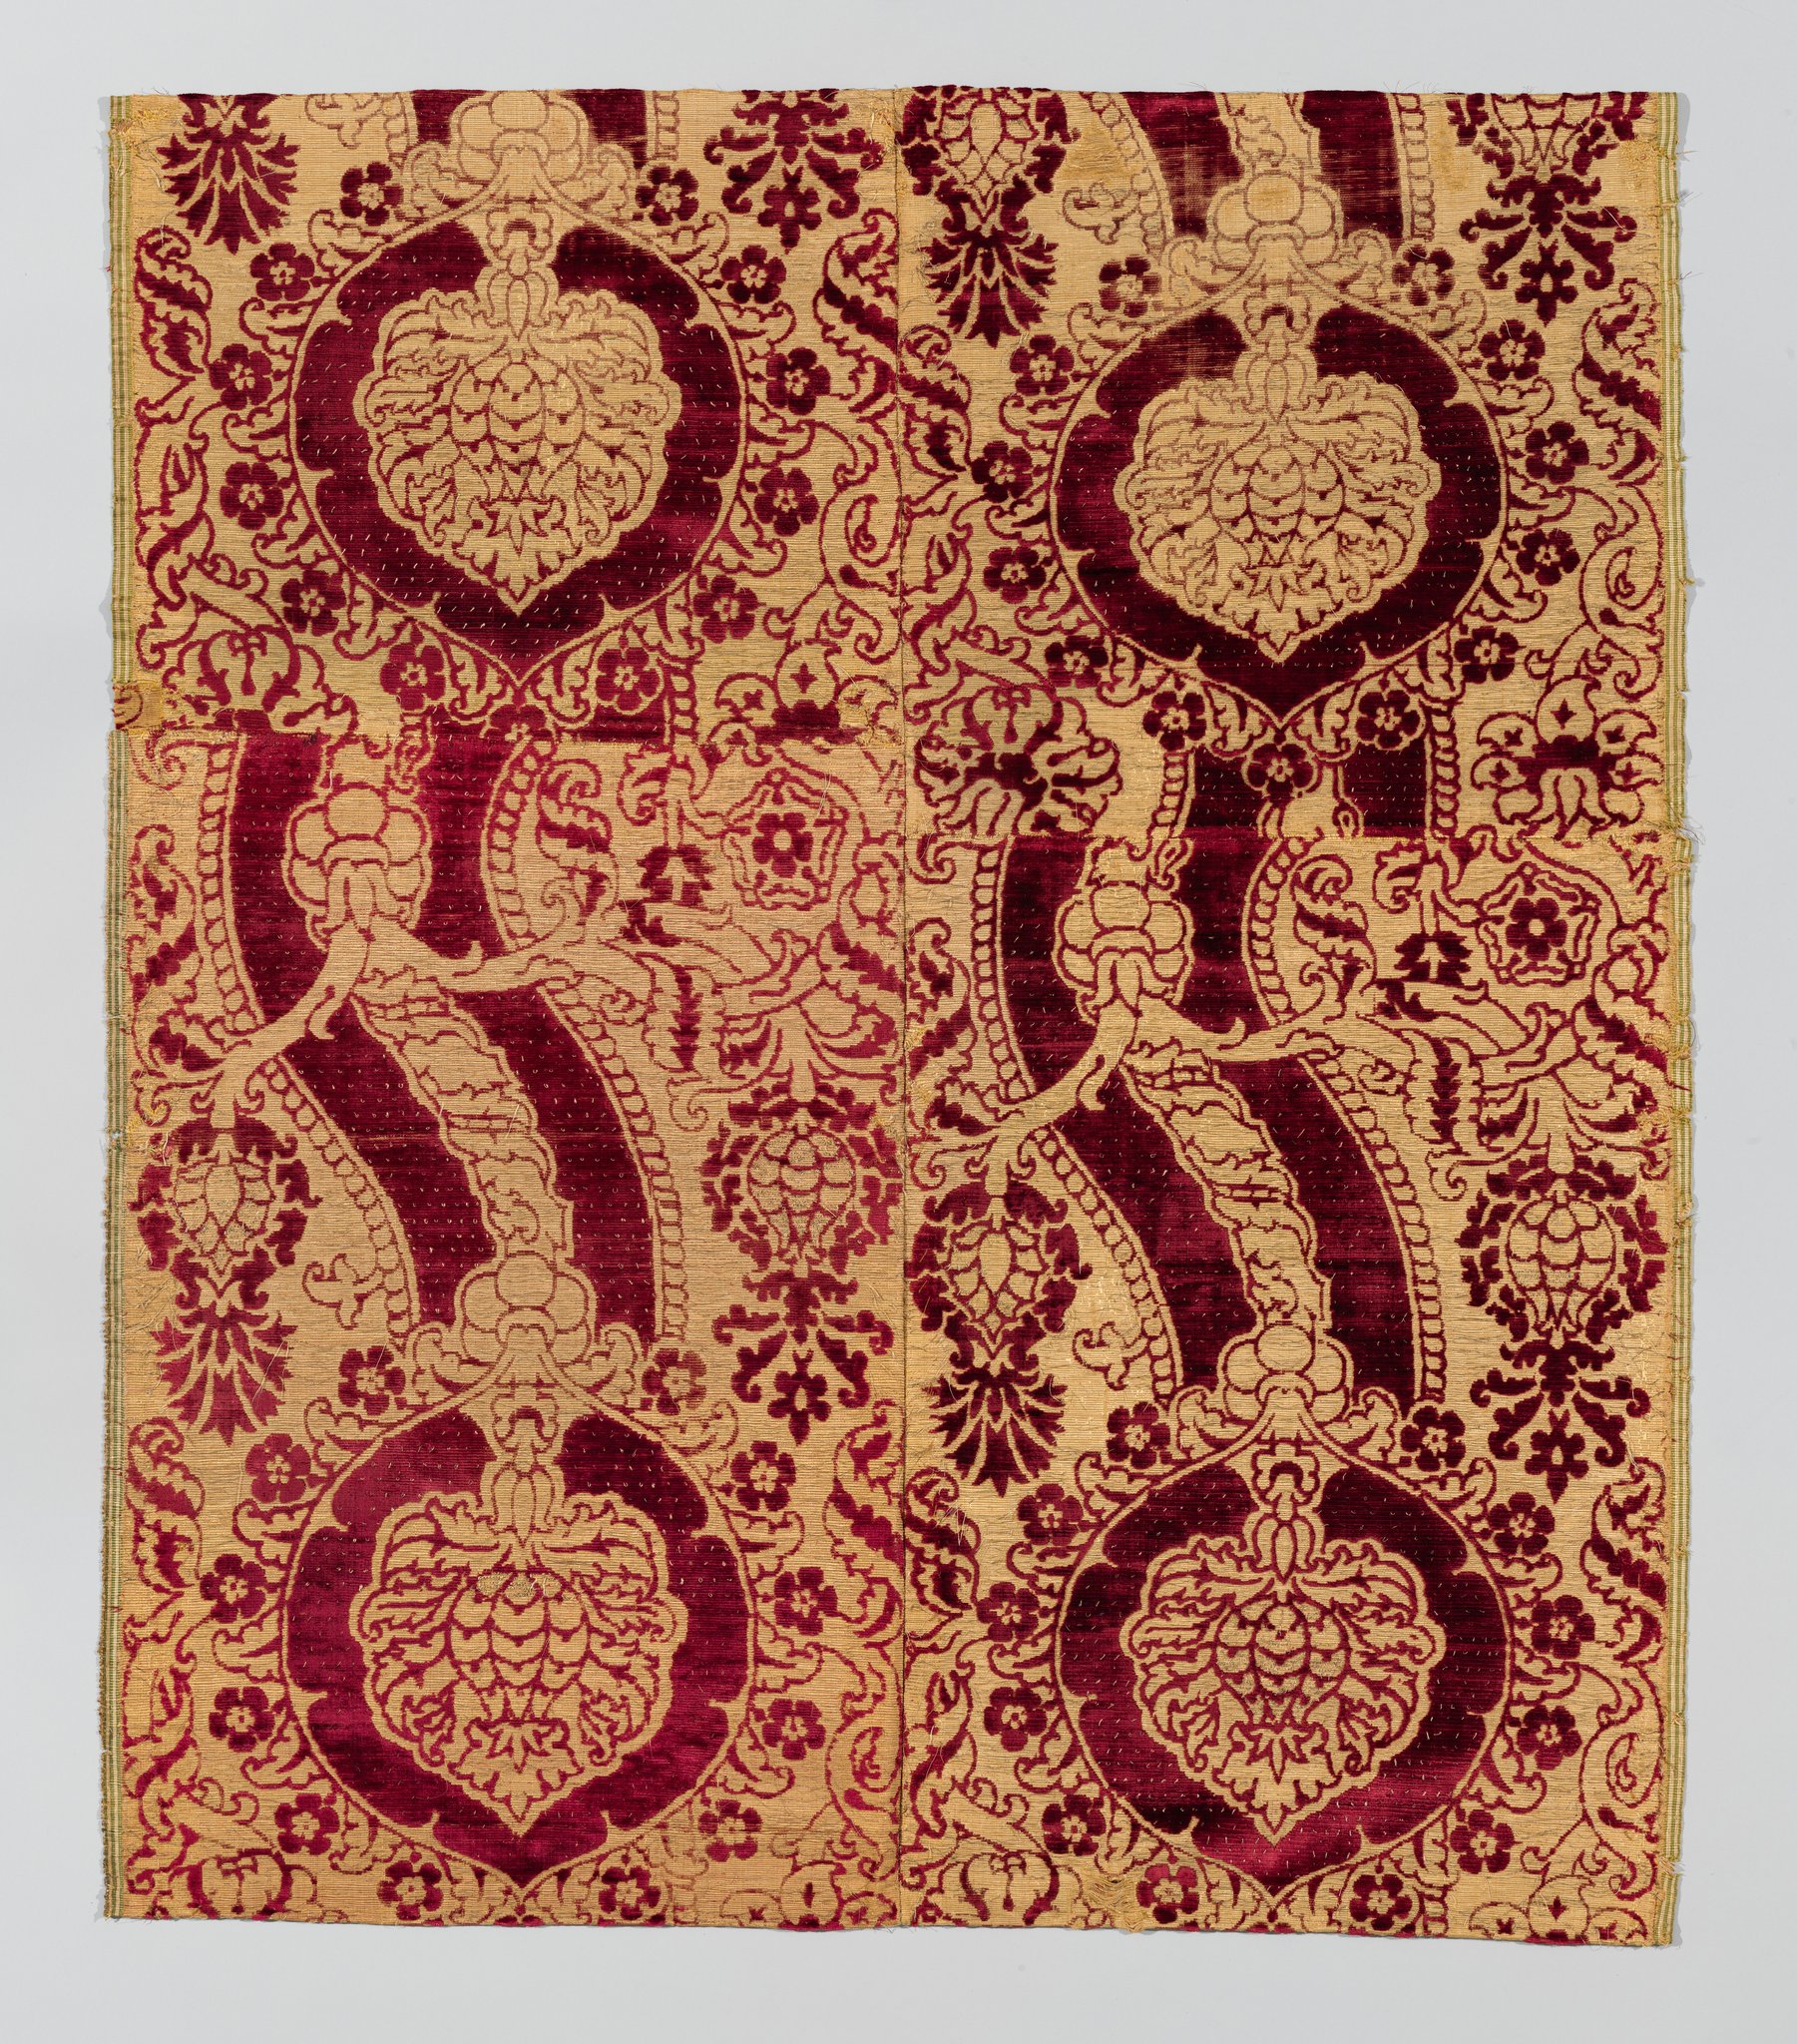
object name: panel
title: Panel of velvet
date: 1467-1500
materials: metal thread, silk